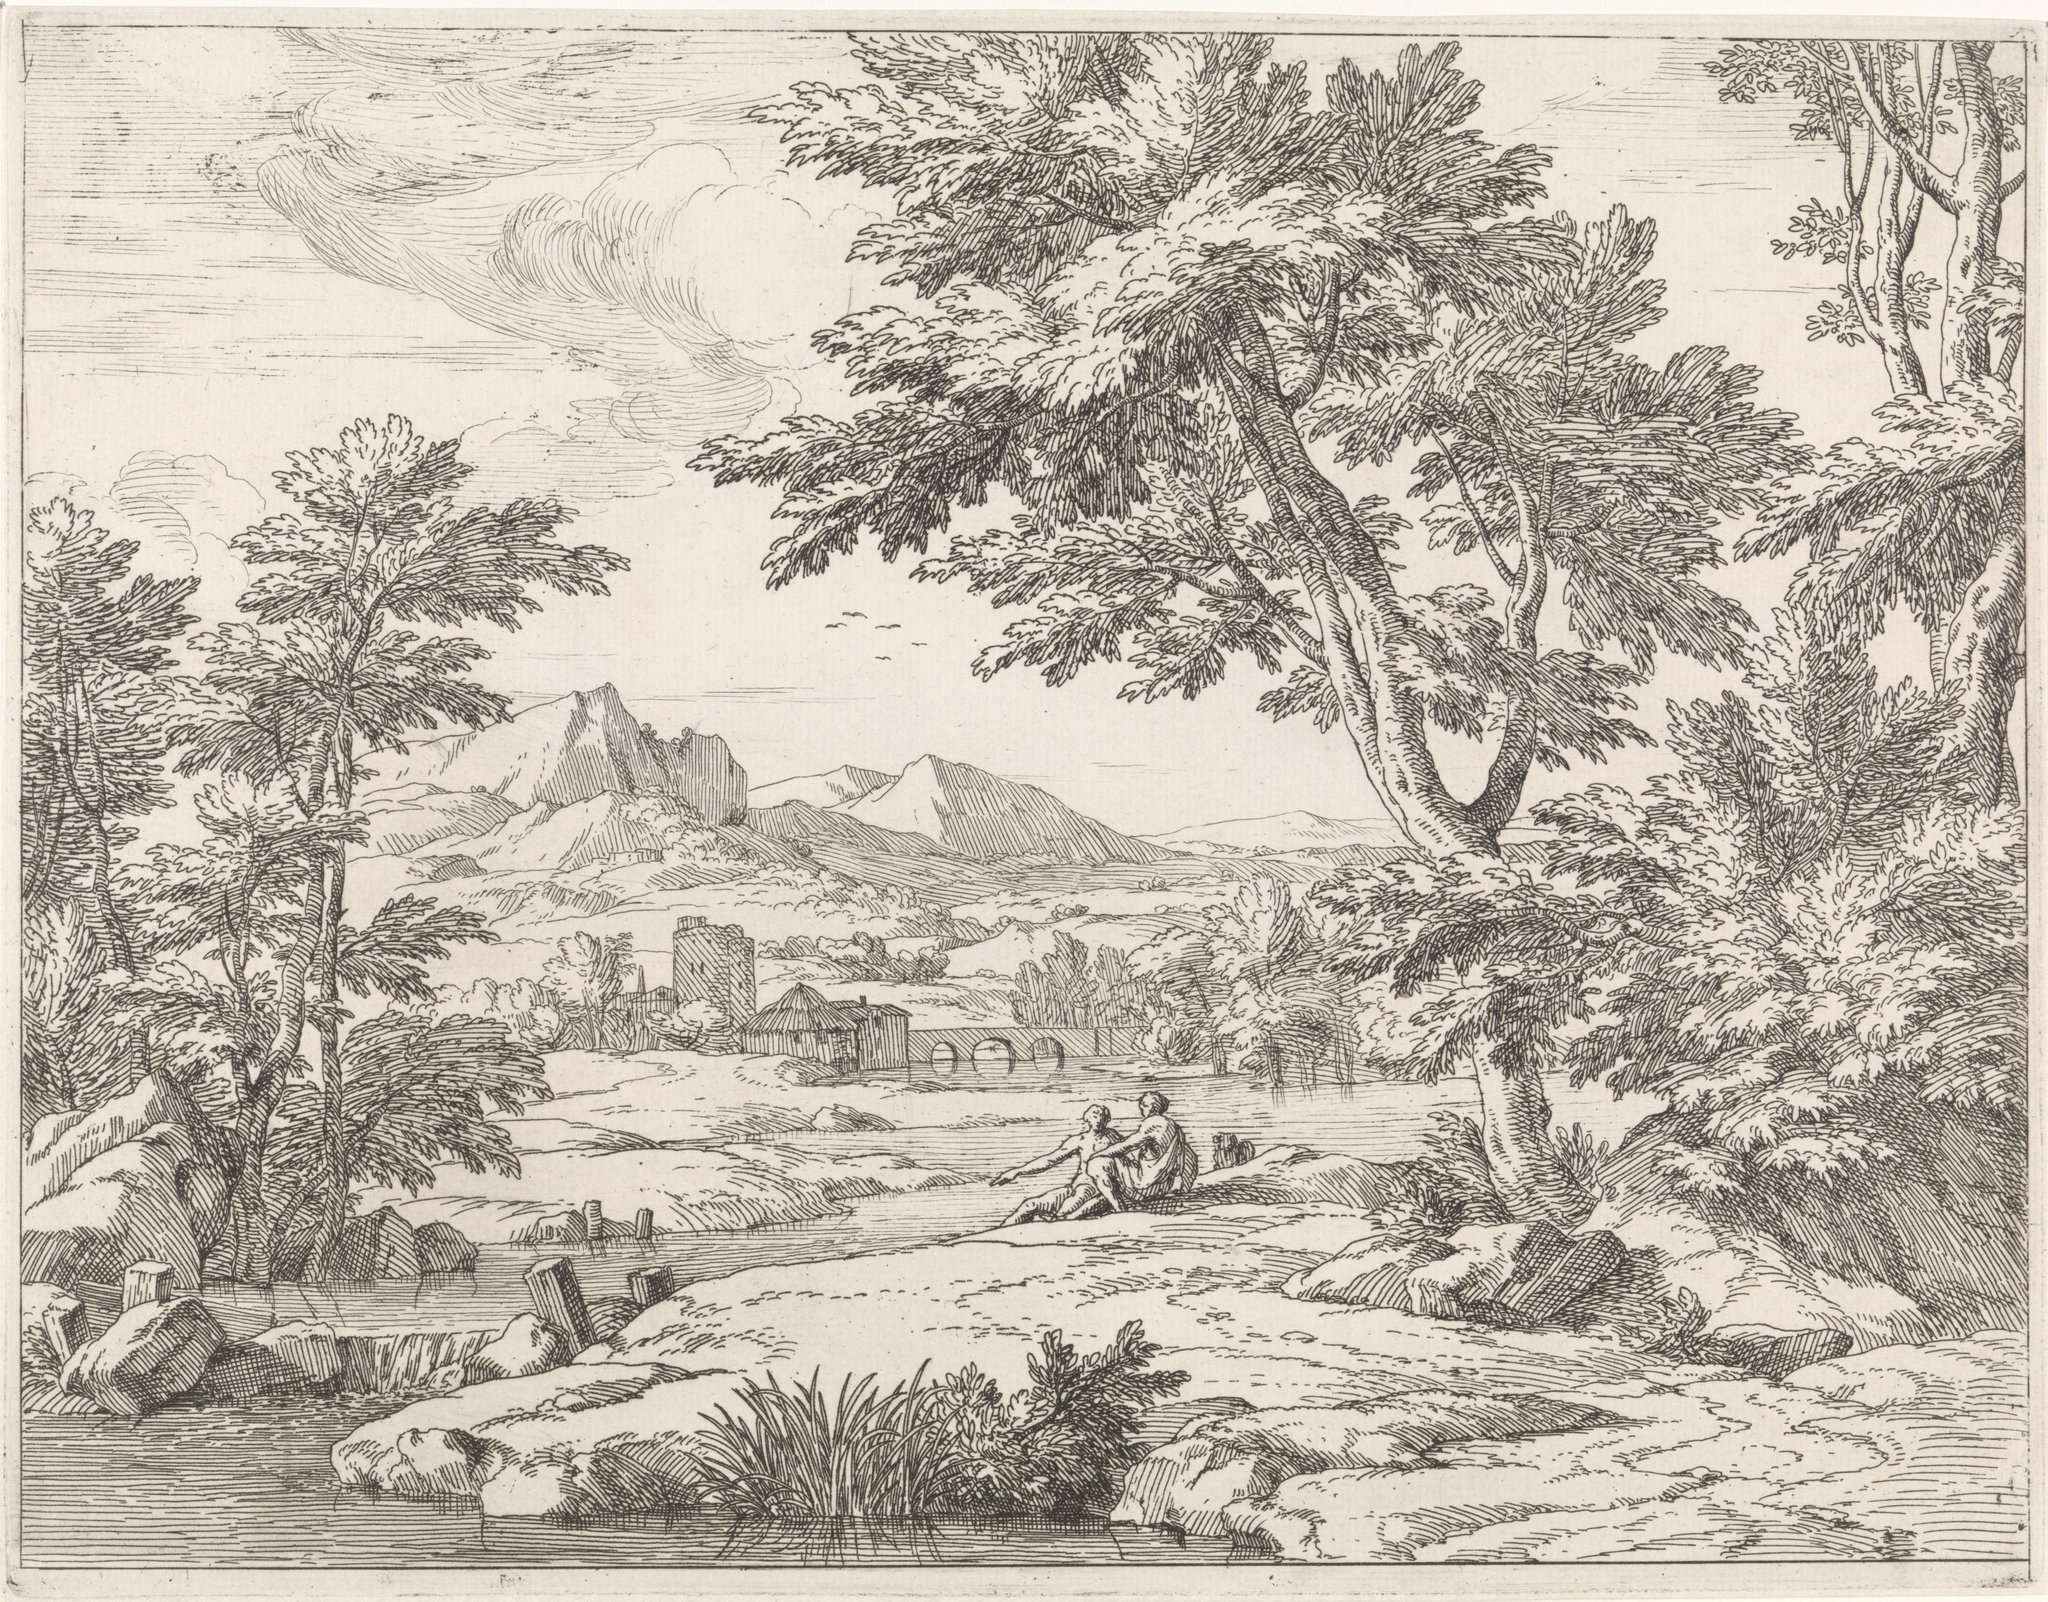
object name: print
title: Rivierlandschappen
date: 1650-1690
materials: paper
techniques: etching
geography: paris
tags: low hill country, landscape with bridge, viaduct or aqueduct, river (+ landscape with figures, staffage)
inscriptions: : Lugt 240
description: Een heuvelachtig landschap met een rivier. Op de voorgrond twee rustende wandelaars, gezeten op de oever van de rivier. Op de achtergrond en dorp met een brug. De prent maakt deel uit van een serie van rivierlandschappen.